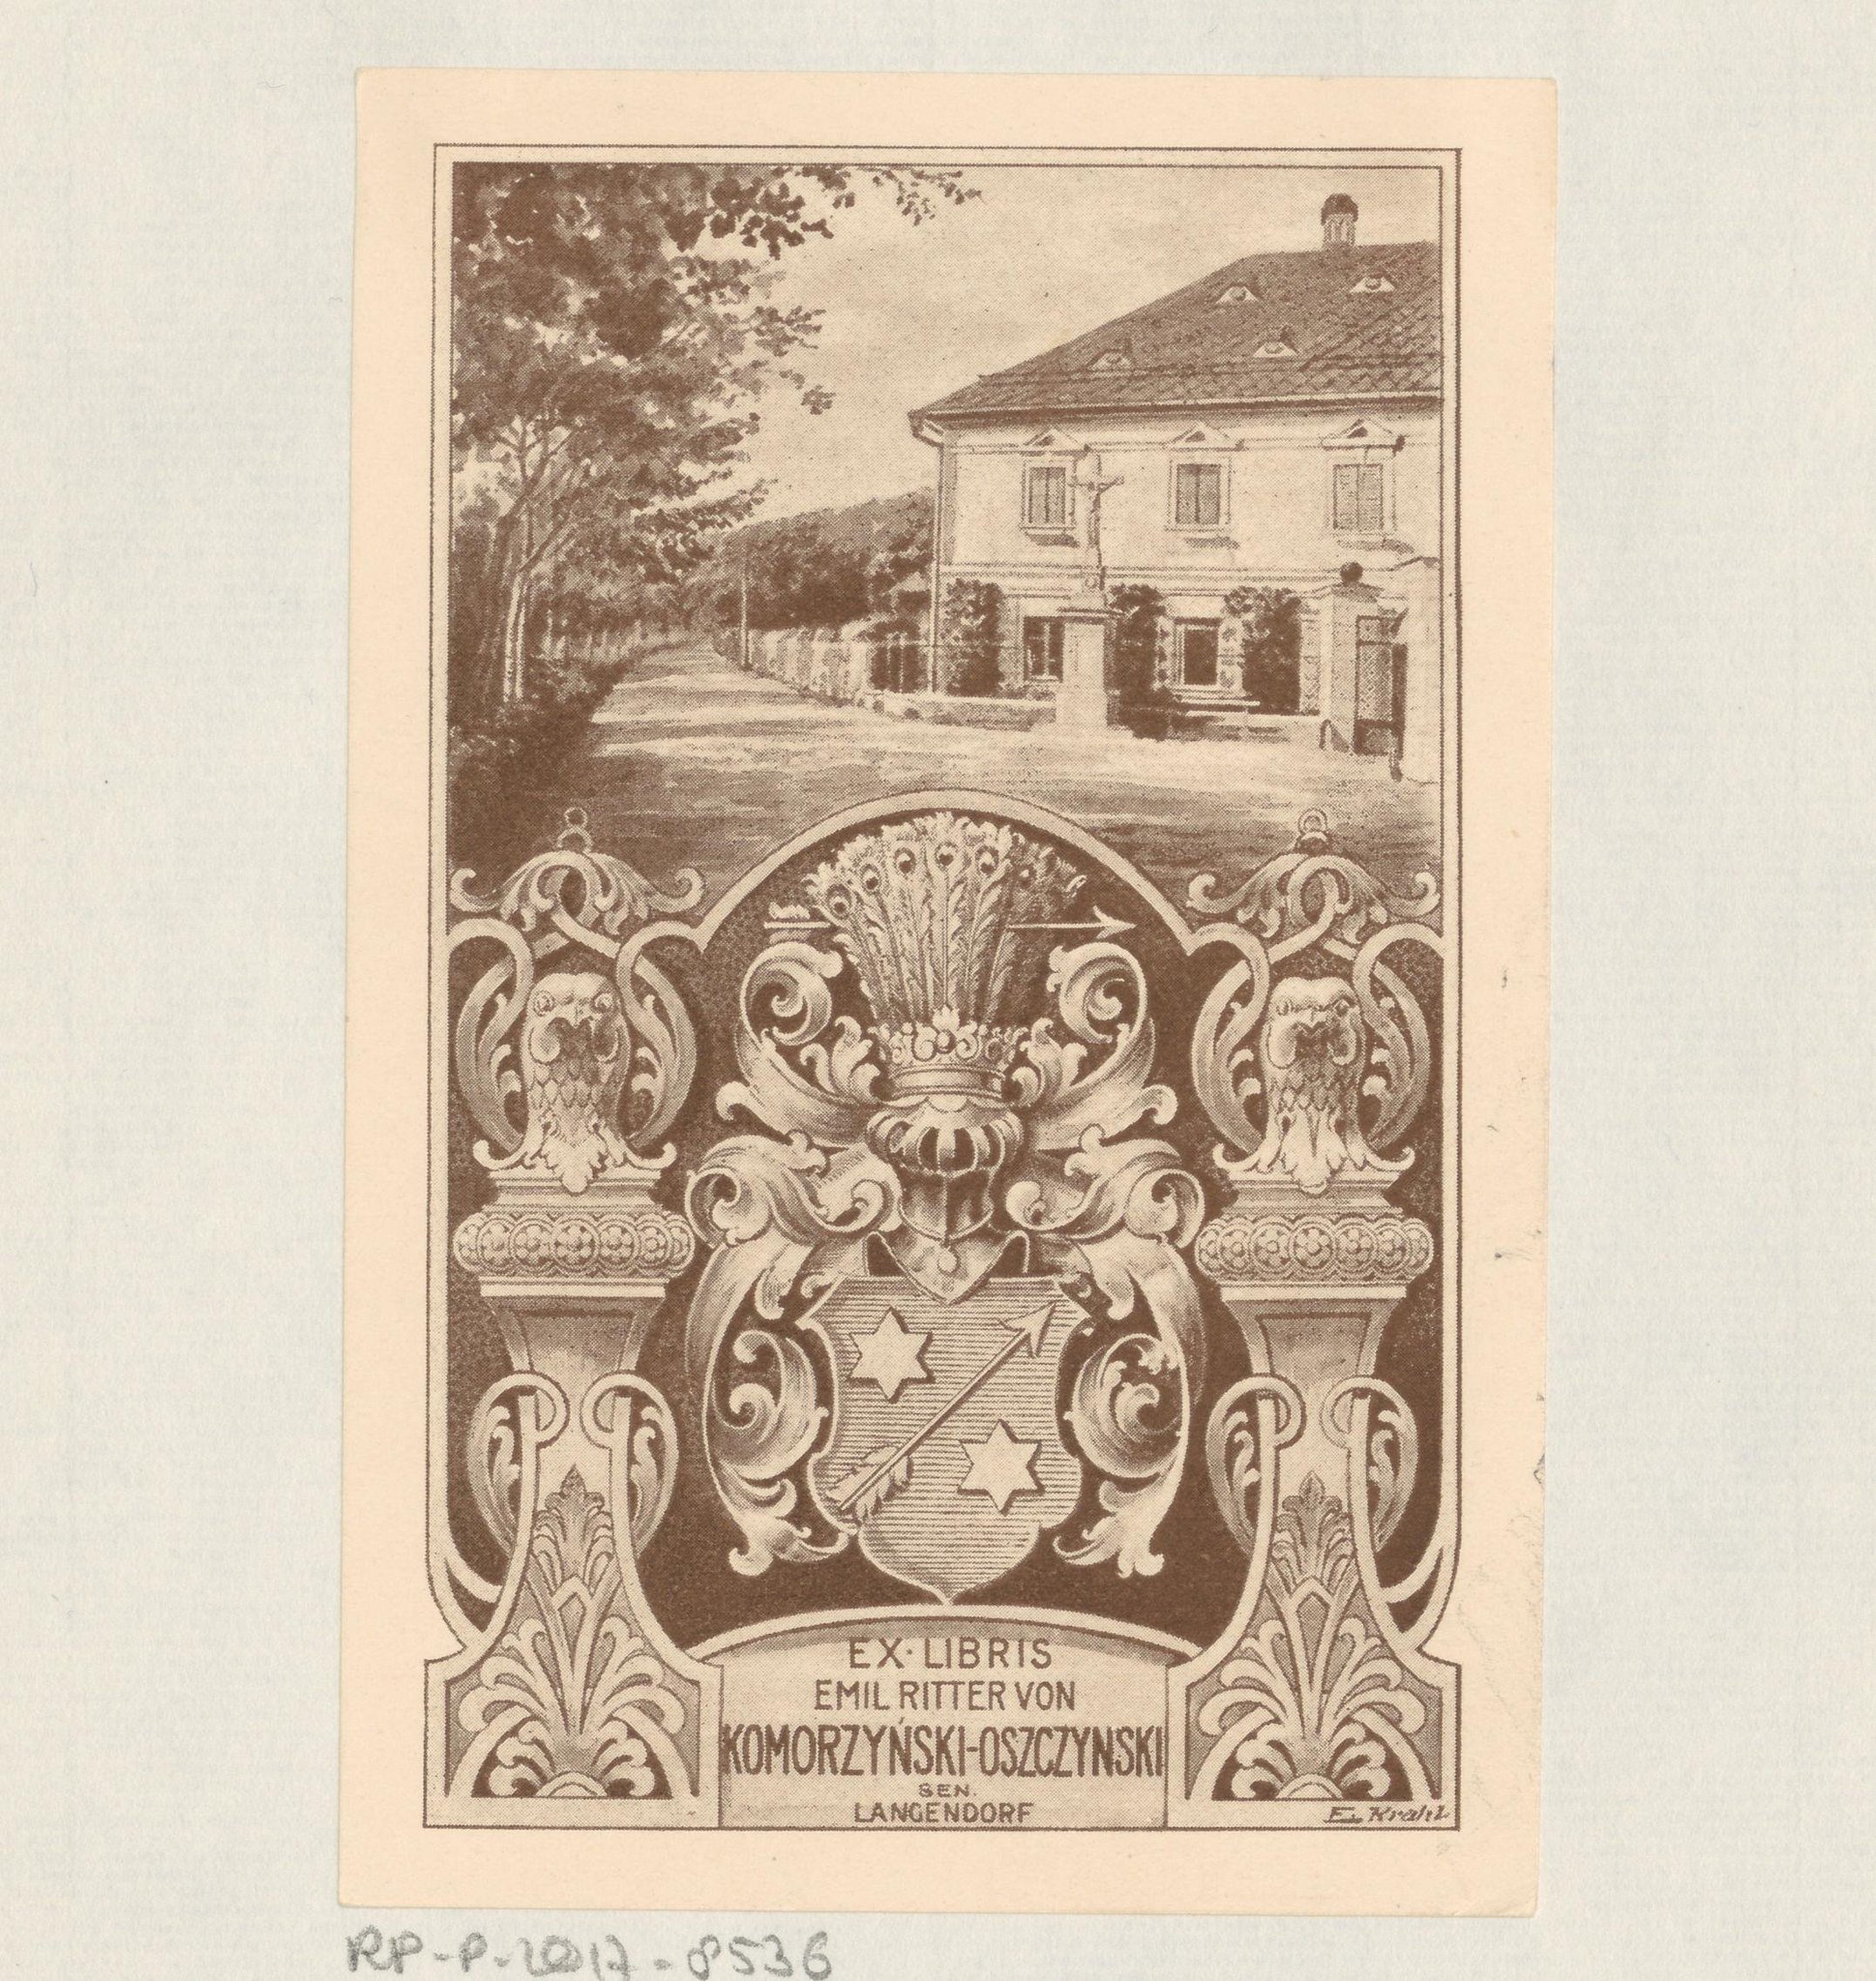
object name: photomechanical print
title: Ex libris van Emil Ritter von Komorzynski-Oszczynski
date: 1870-1924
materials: paper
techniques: autotype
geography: czech republic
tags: housing, armorial bearing, heraldry